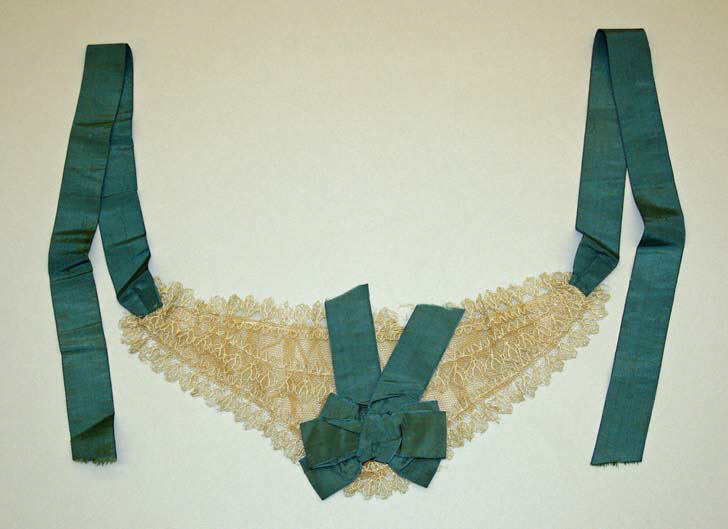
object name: cap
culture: european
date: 1880-1889